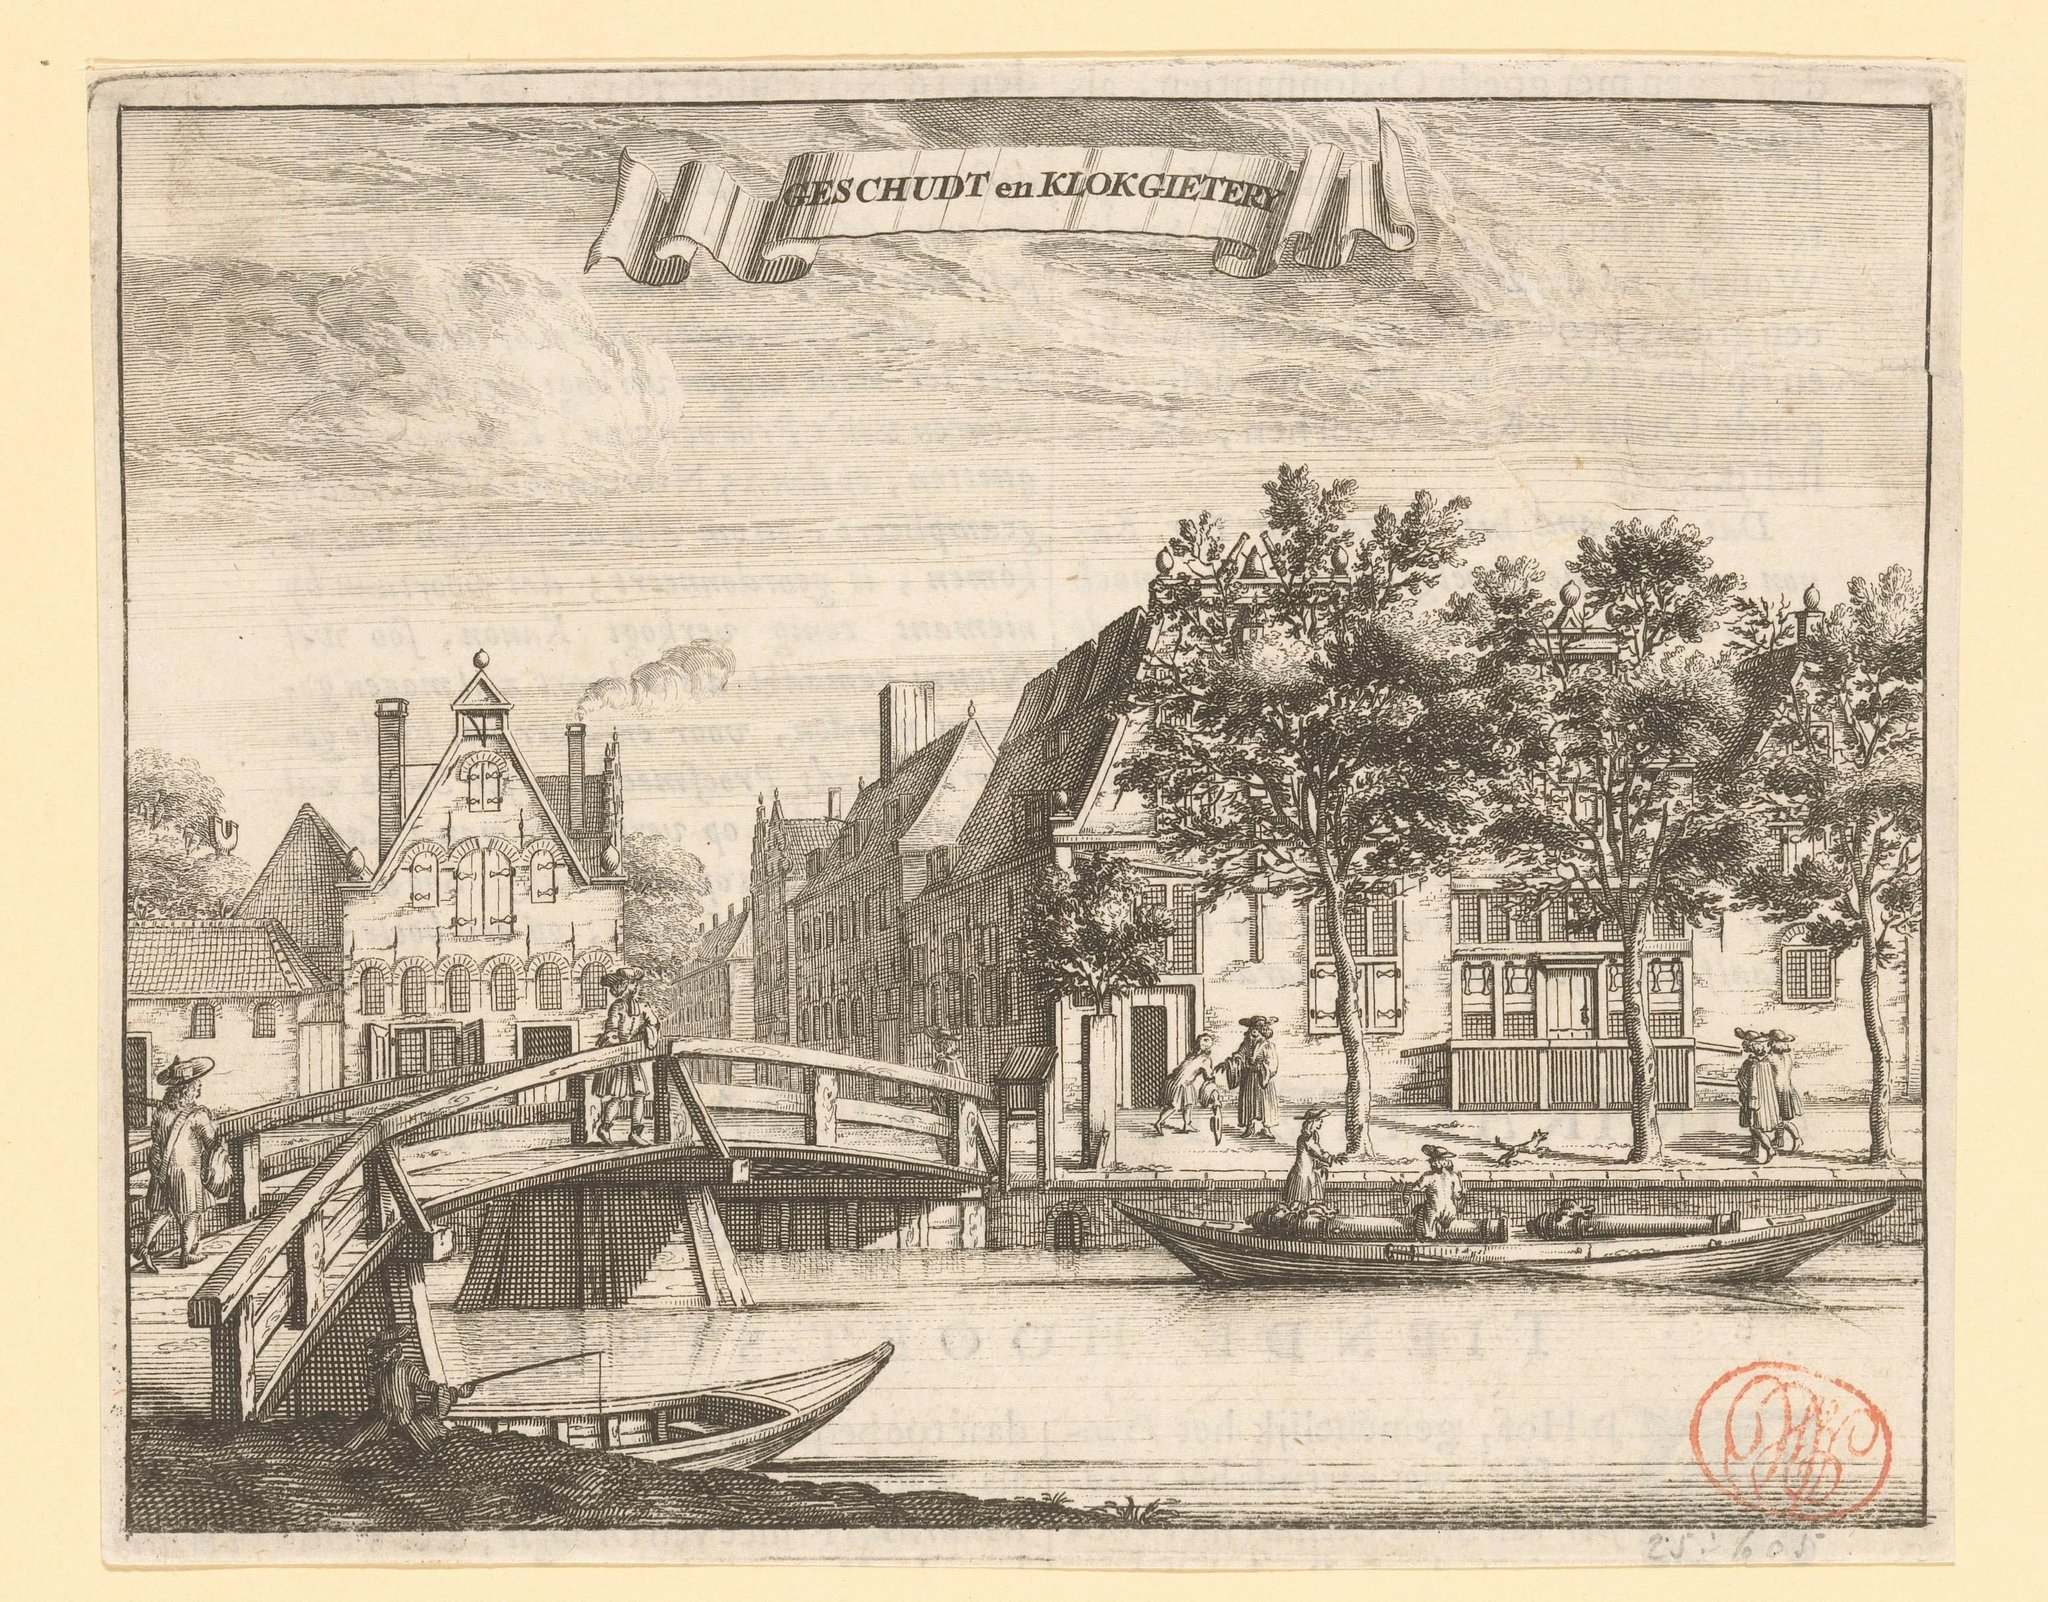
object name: book illustration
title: Gezicht op de Stads Geschut-en Klokkengieterij aan de Lijnbaansgracht te Amsterdam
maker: Anonymous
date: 1693-1694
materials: paper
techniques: engraving, etching, letterpress printing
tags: bell-founder, factory-building, canals, waters (in city) (+ city(-scape) with figures, staffage), street (+ city(-scape) with figures, staffage)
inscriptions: collector's mark: Lugt 195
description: Prent gebruikt in: Commelin, Caspar. Beschryvinge van Amsterdam, desselfs eerste oorspronk uyt den Huyse (…). 2 delen. Amsterdam: Abraham Wolfgang, Gillis Janssonius van Waesberge, Johannes Janssonius van Waesberge II, weduwe Dirk Boom I, Hendrick Boom en Rembertus Goethals, 1693. Of in: Commelin, Caspar. Beschryvinge van Amsterdam, zynde een naukeurige verhandelinge van desselfs eerste oorspronk uyt (…). 2 delen. Amsterdam: weduwe Aart Dircksz Oossaan, 1694. Latere staat ook gebruikt in: Commelin, Caspar. Beschryvinge van Amsterdam, zynde een naukeurige verhandelinge van desselfs eerste oorspronk uyt (…). 2 delen. 2e druk. Amsterdam: Andries van Damme, Johannes Ratelband, weduwe A. van Aaltwyk en Hermanus Uytwerf, 1726.